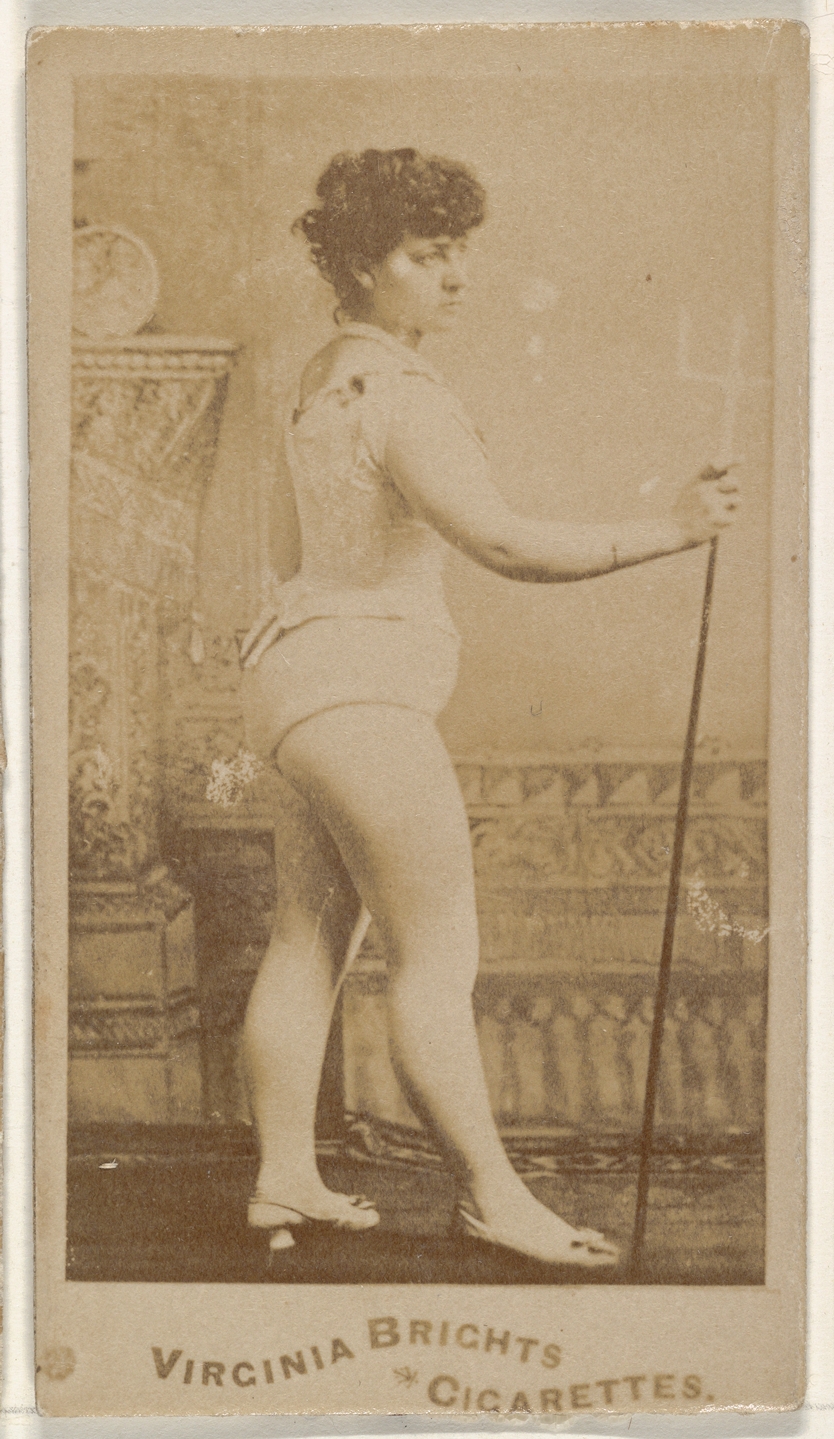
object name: photograph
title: From the Actors and Actresses series (N45, Type 5) for Virginia Brights Cigarettes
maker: allen & ginter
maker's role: publisher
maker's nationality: american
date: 1888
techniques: albumen silver print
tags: portraits,women,actresses